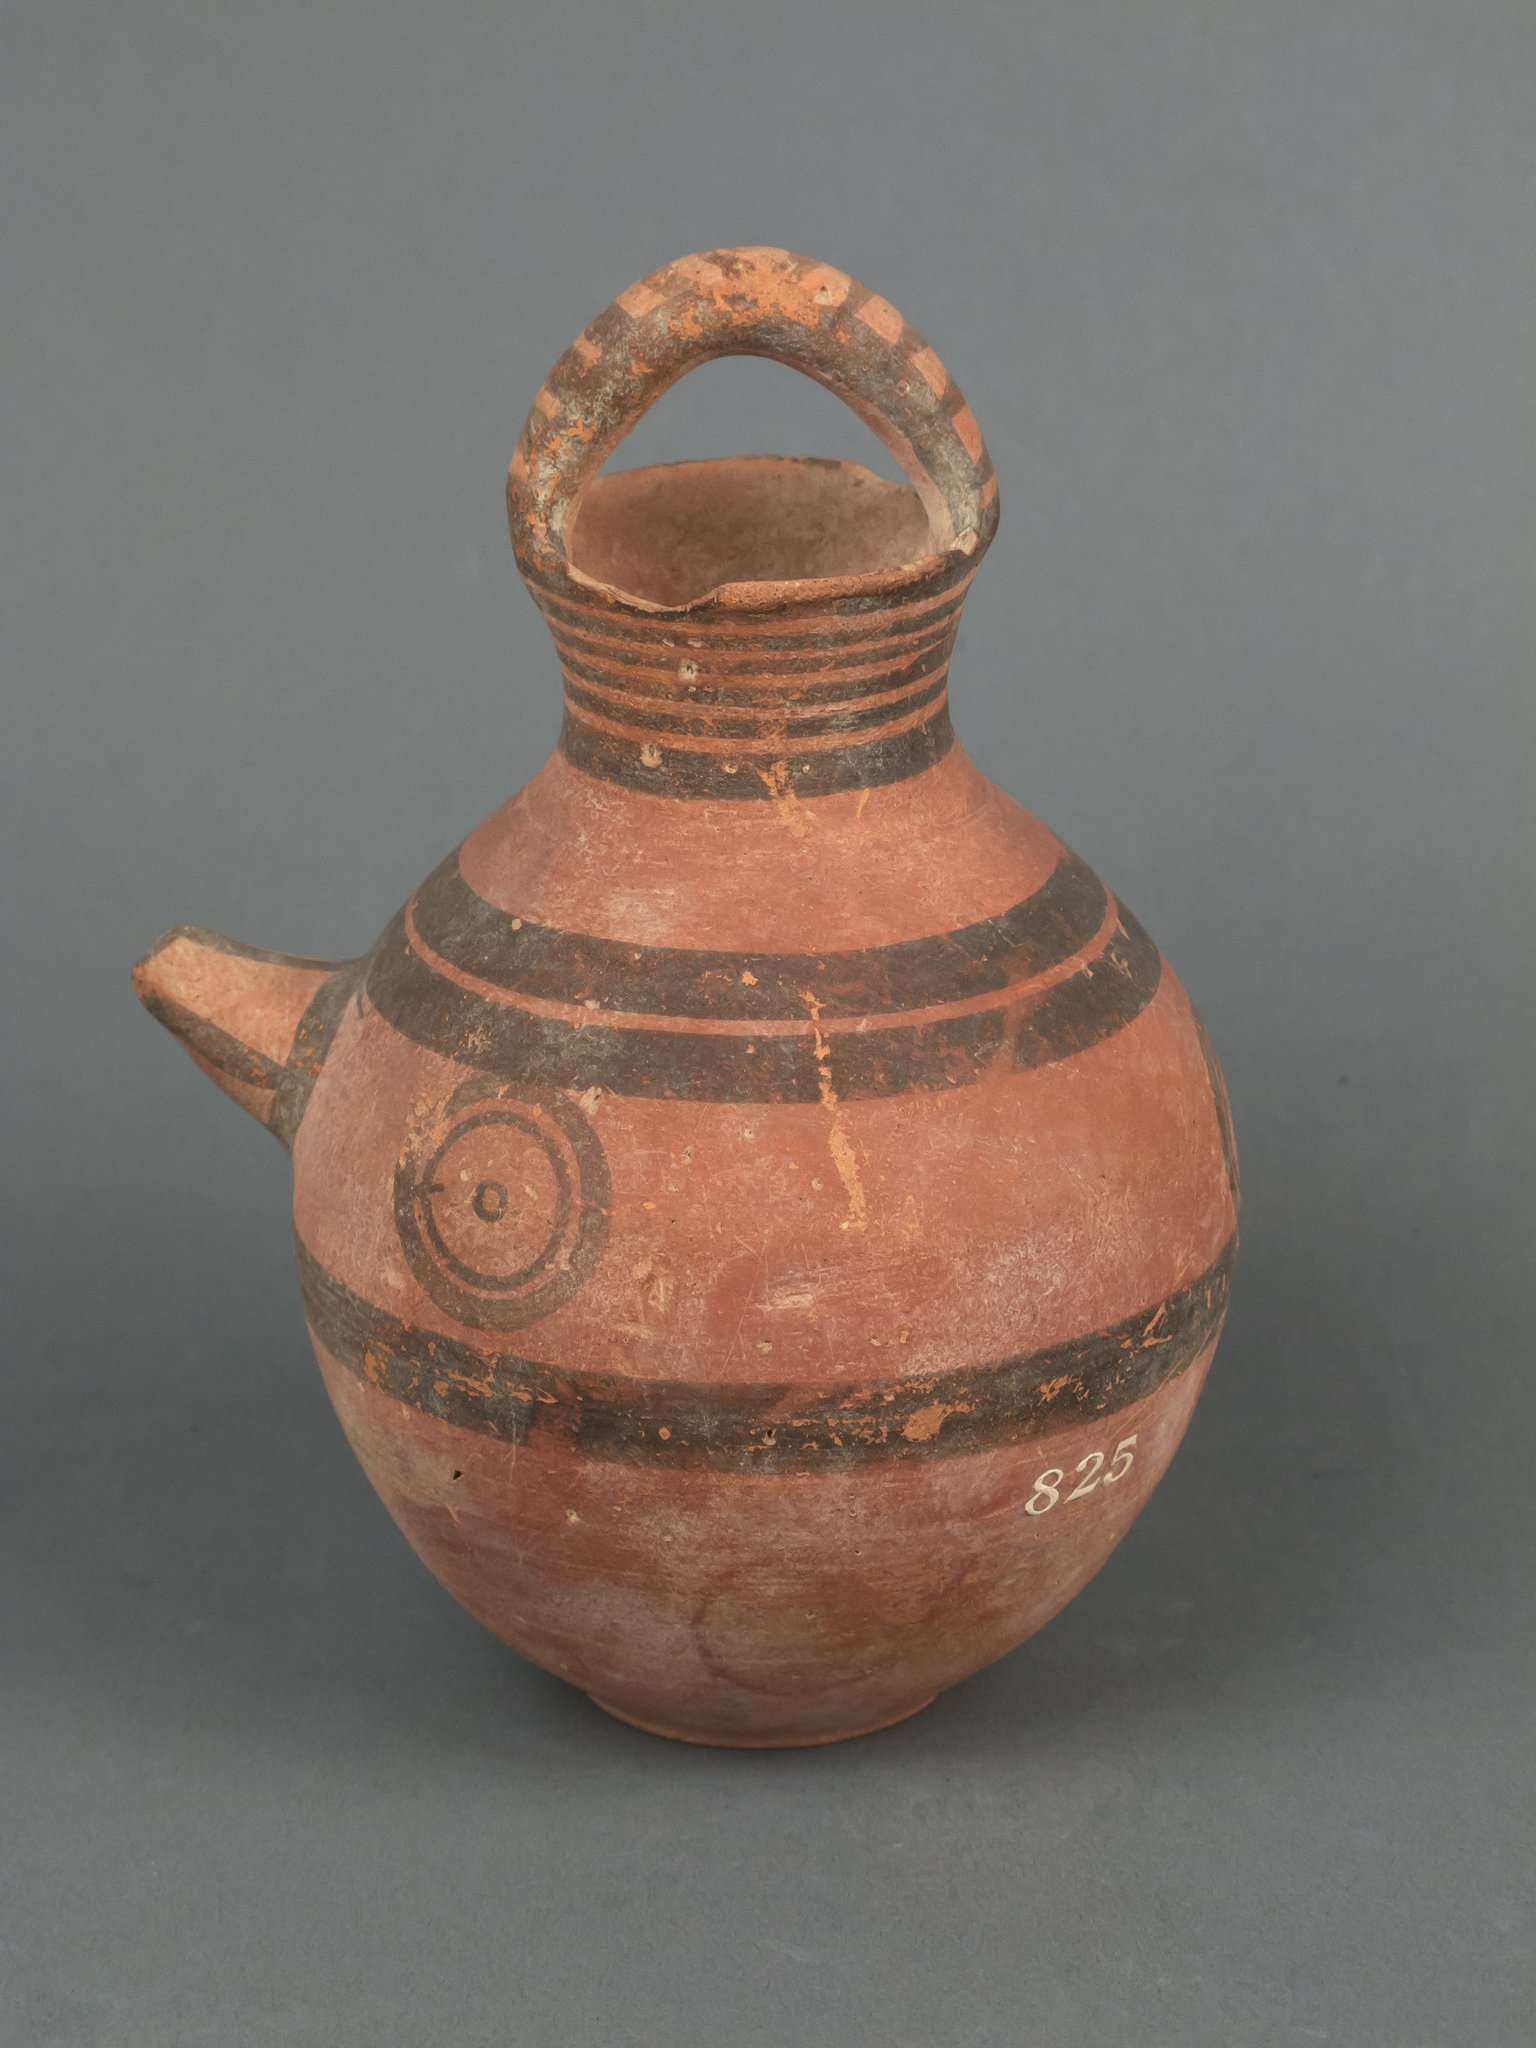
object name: jug, spouted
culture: cypriot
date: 750-600 BCE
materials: terracotta